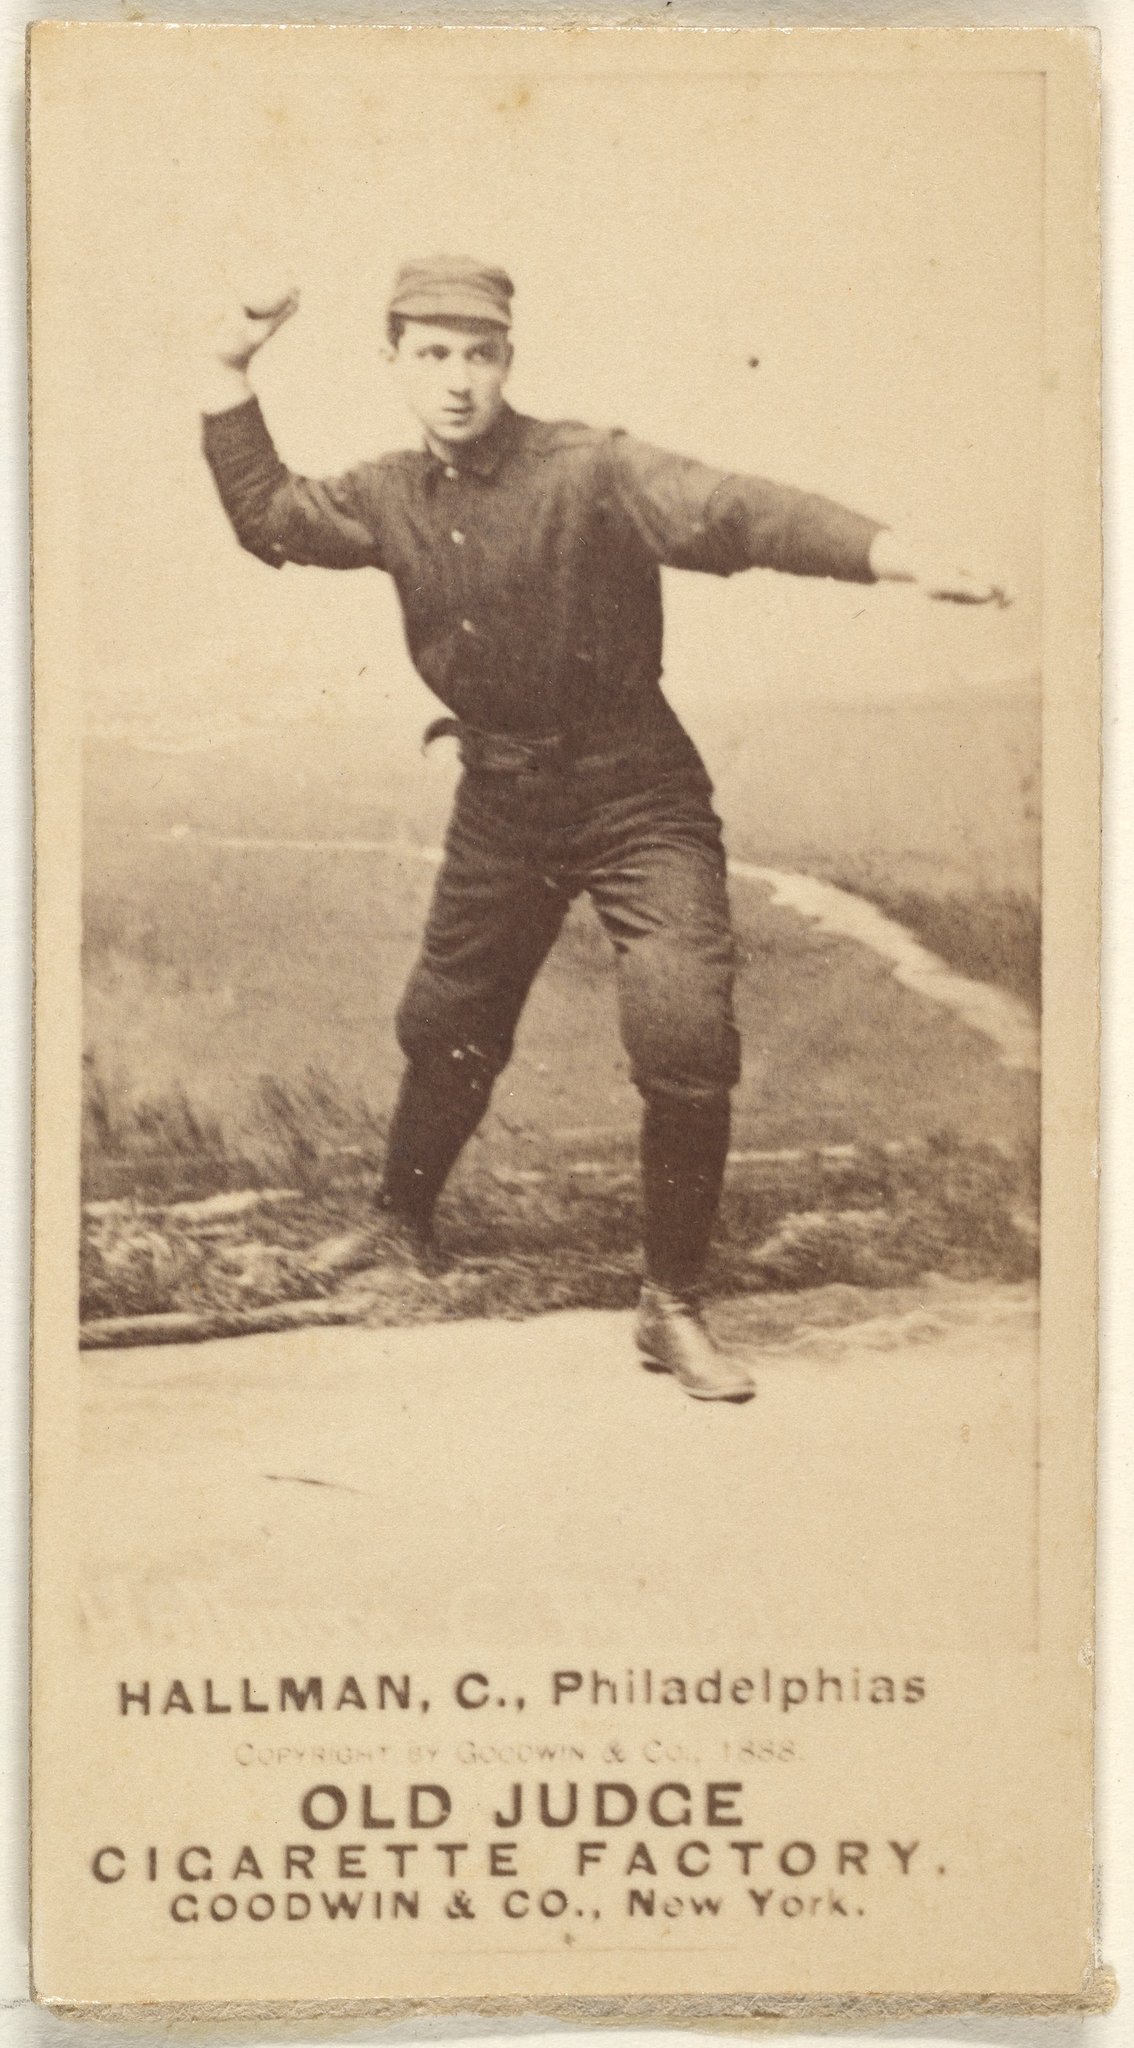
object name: baseball card, photograph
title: William Wilson "Bill" Hallman, Catcher, Philadelphia, from the Old Judge series (N172) for Old Judge Cigarettes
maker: goodwin & company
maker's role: publisher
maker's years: 1850-1950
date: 1888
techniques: albumen silver print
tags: men,portraits,baseball,athletes